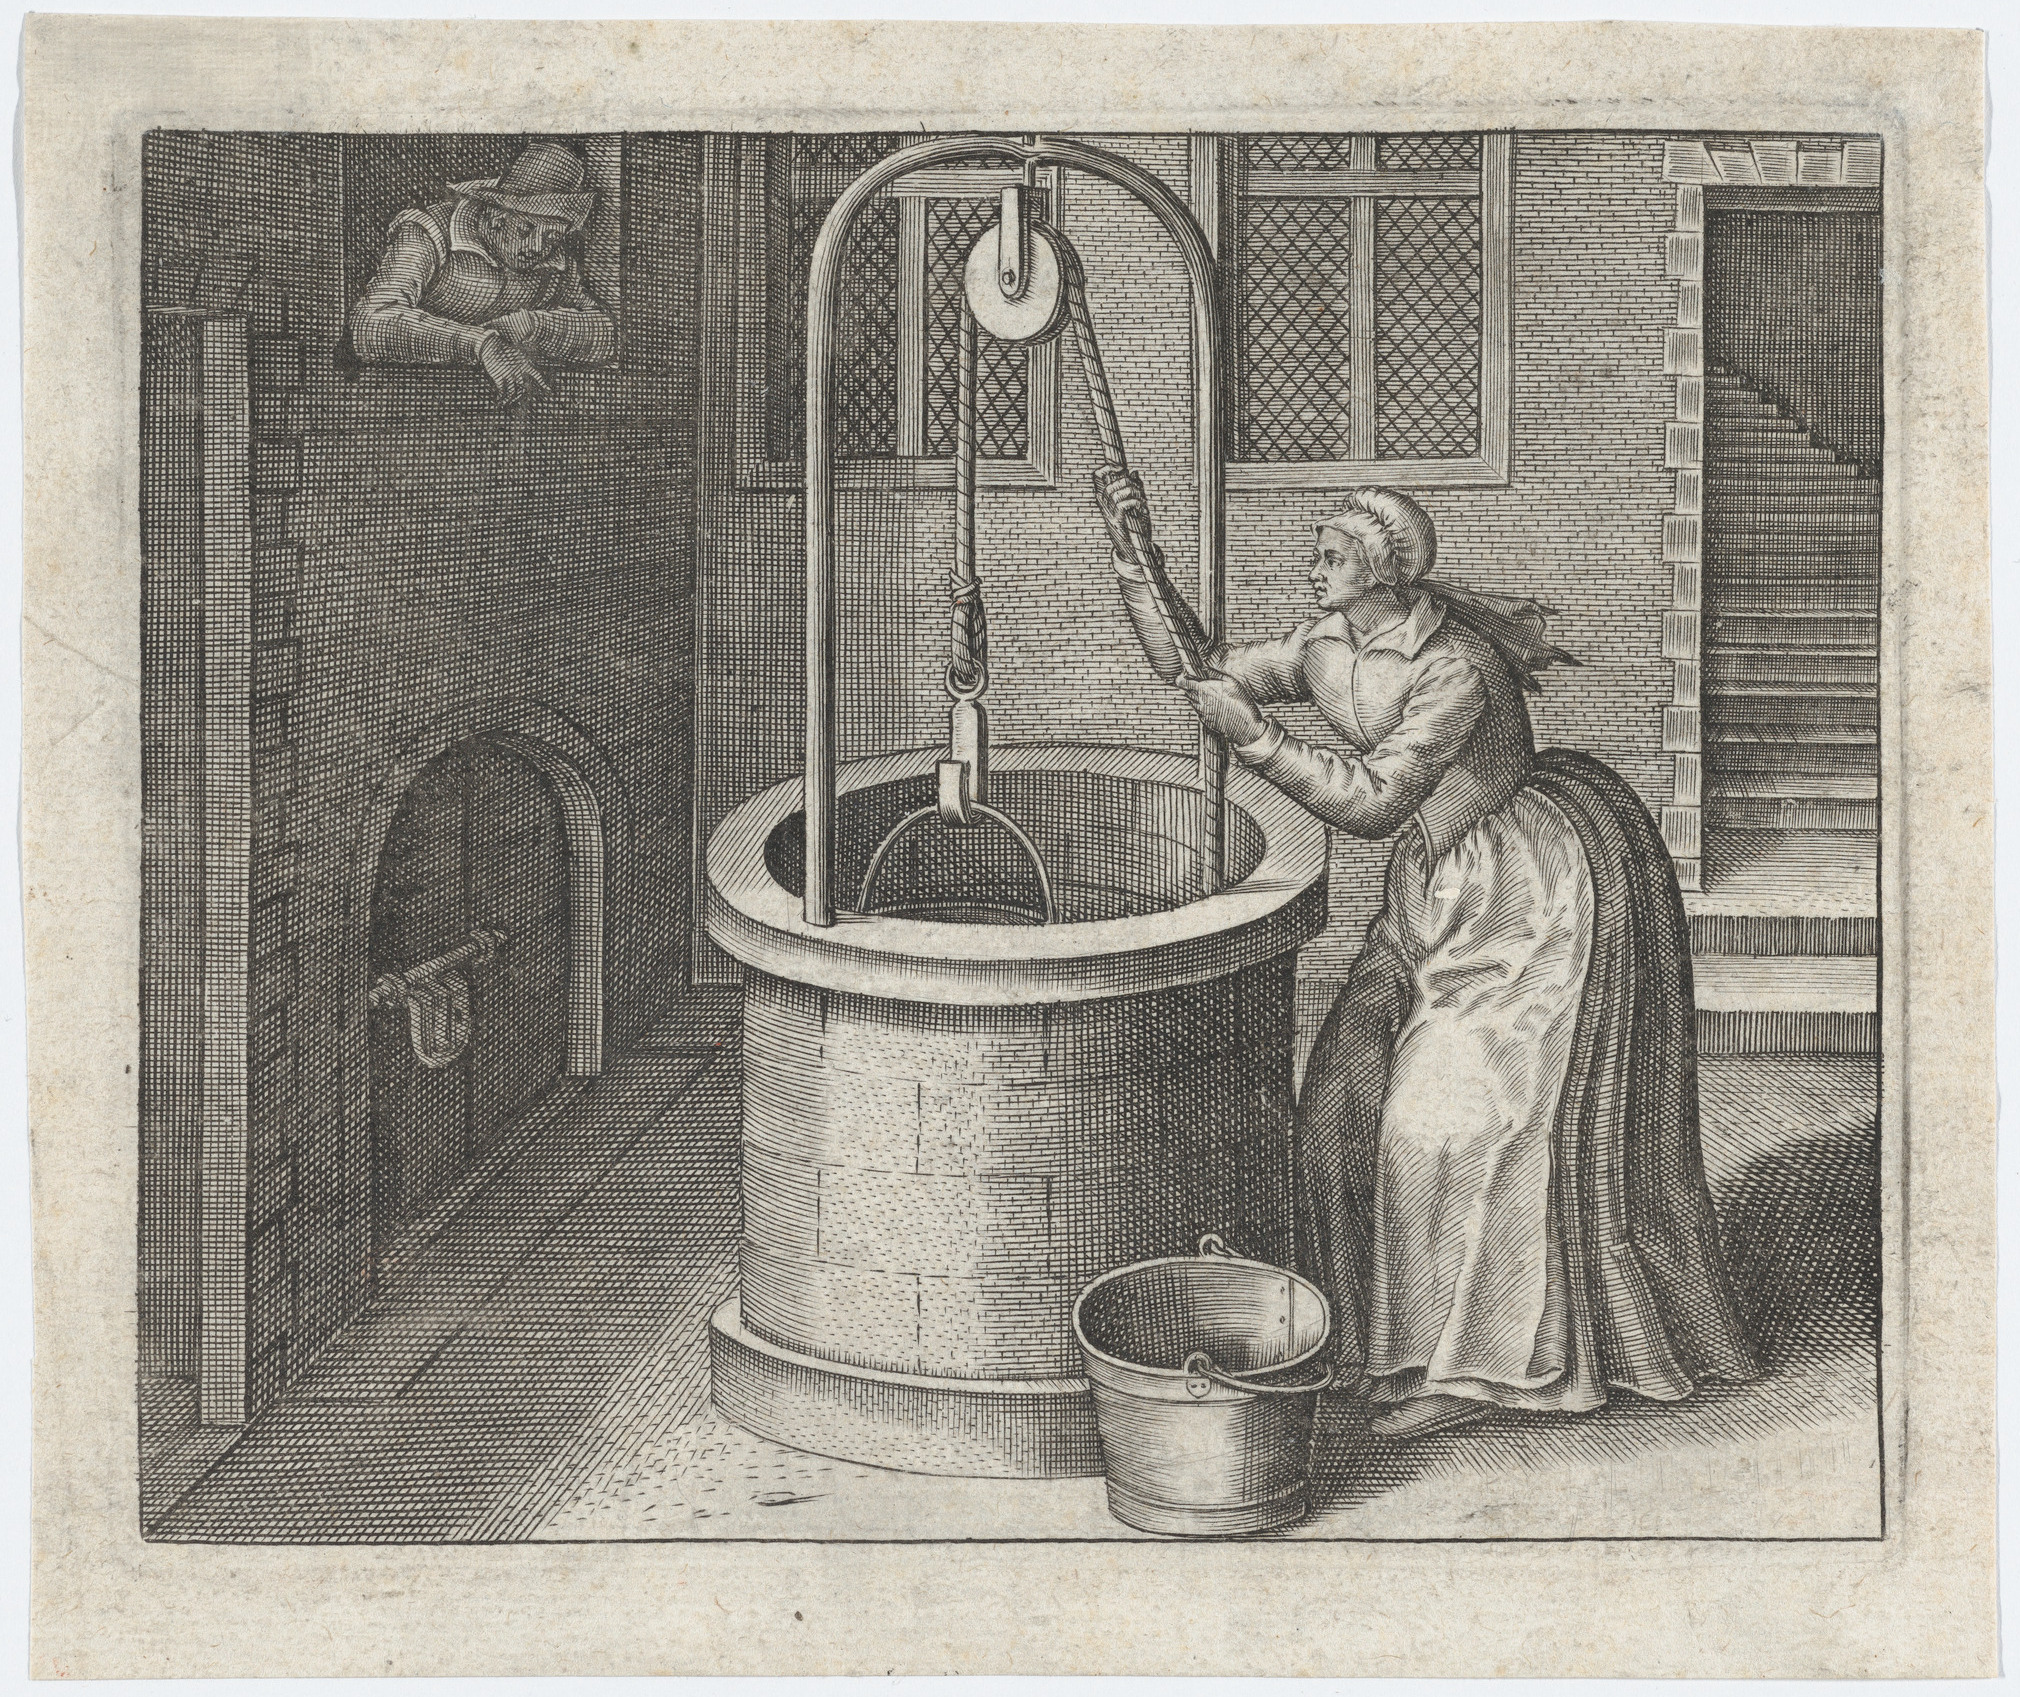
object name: print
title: Enigmes Joyeuses pour les Bons Esprits, Plate 9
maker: jan van haelbeeck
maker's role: artist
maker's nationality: flemish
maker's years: 1595-1635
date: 1615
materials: copper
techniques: engraving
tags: wells,men,women,buckets